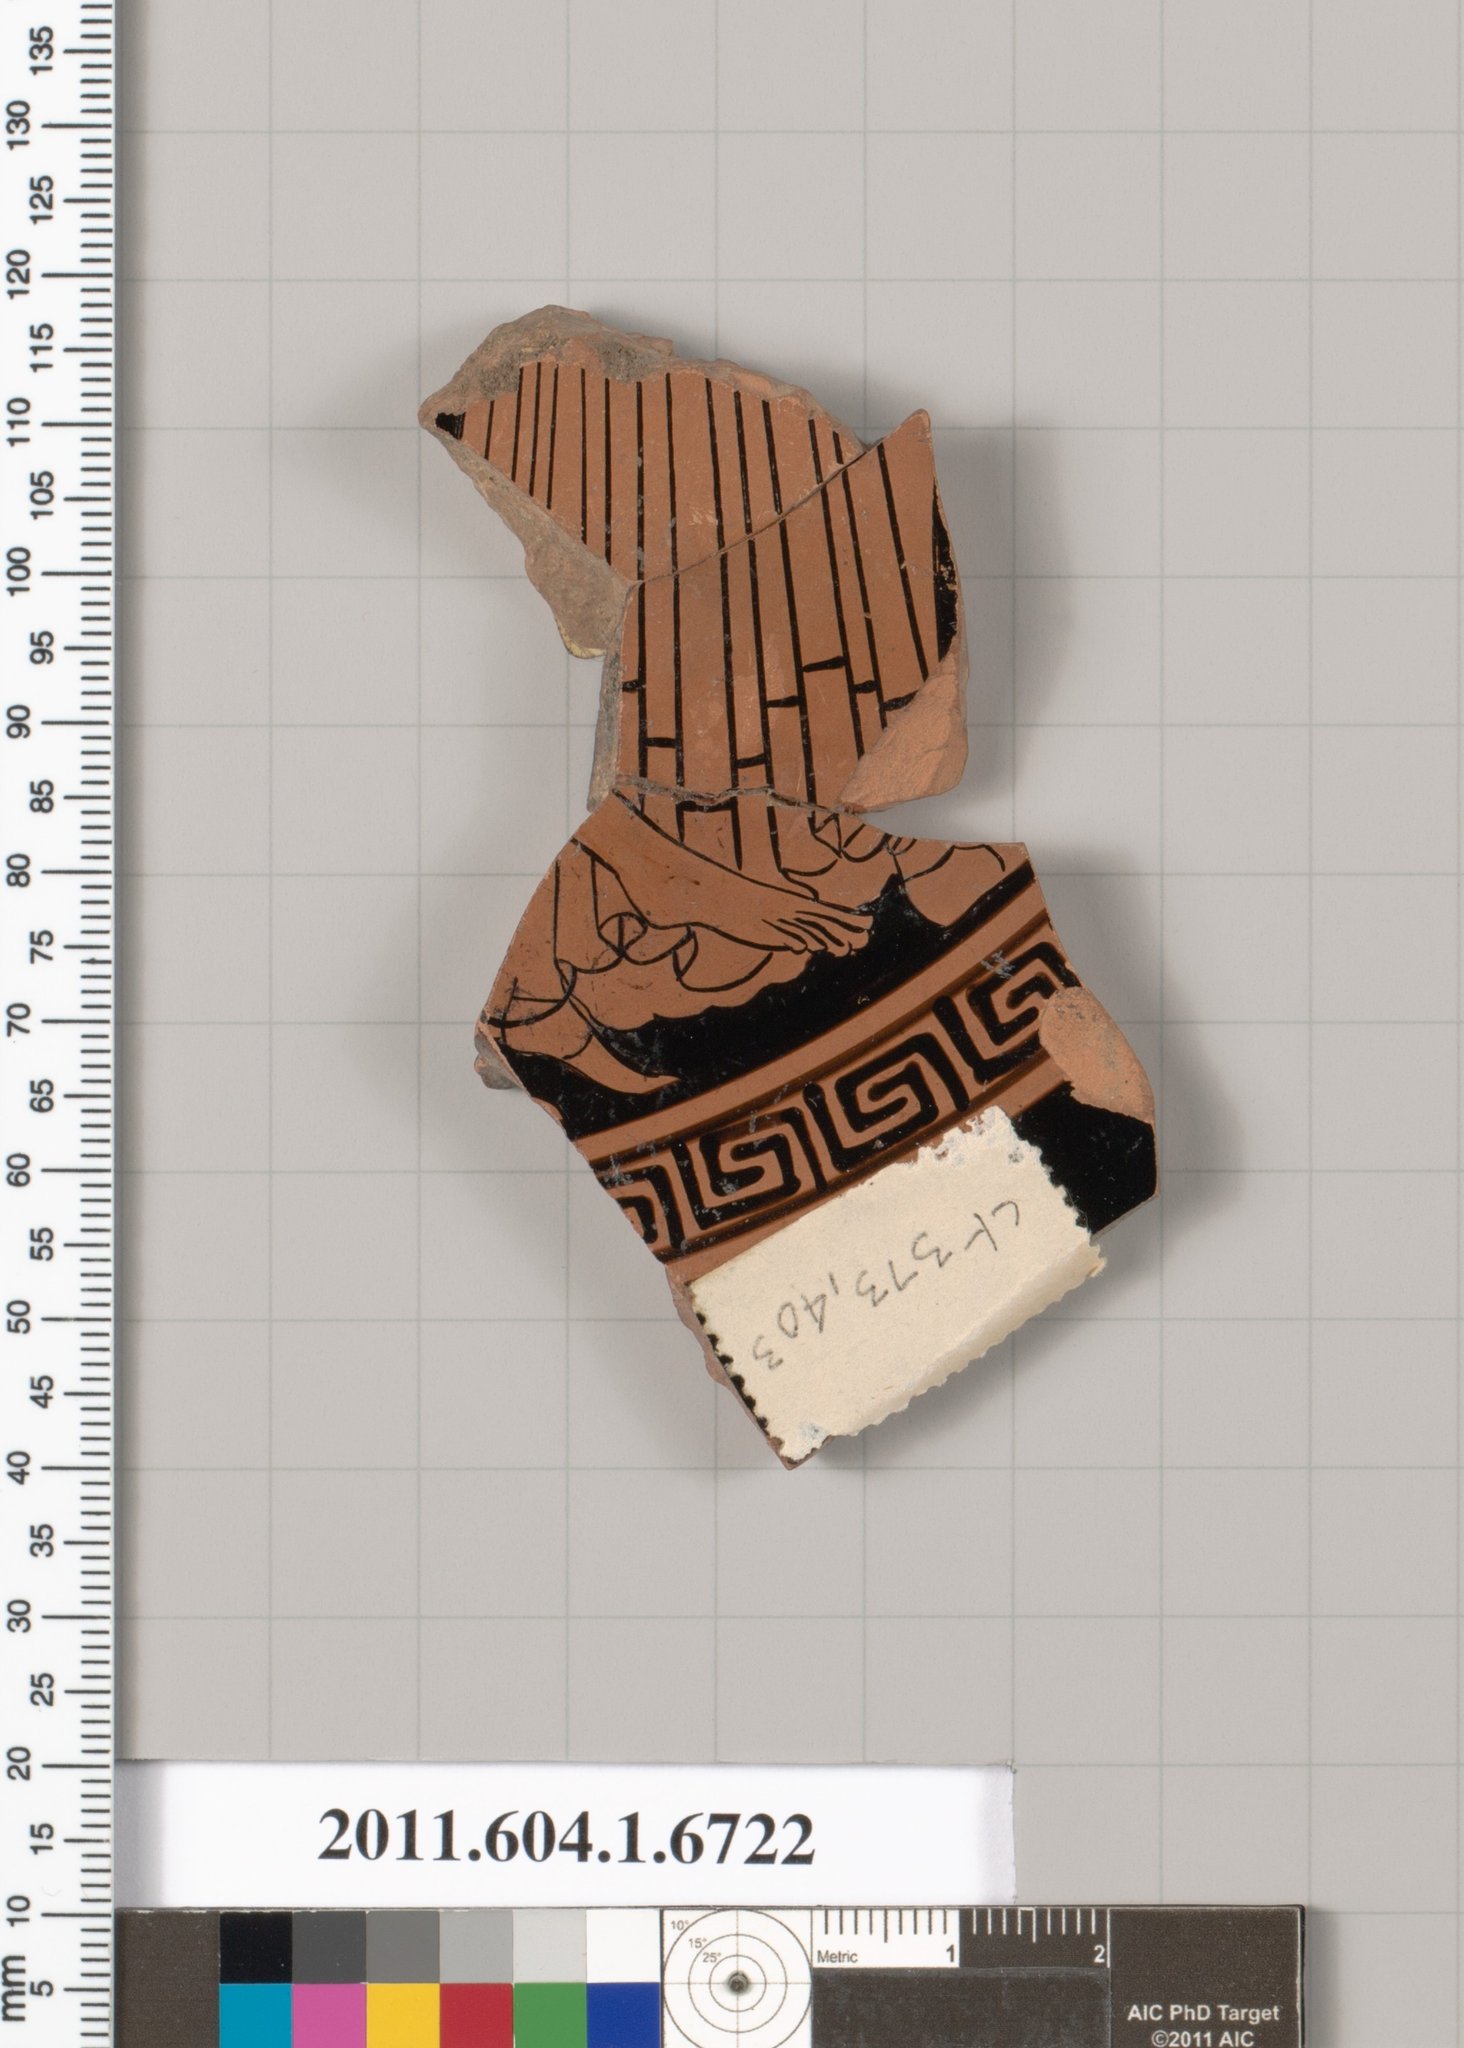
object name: kylix fragment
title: Terracotta fragment of a kylix (drinking cup)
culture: greek, attic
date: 490-470 BCE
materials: terracotta